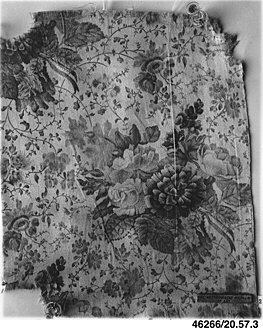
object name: fragment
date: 1801-1900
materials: silk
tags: flowers,leaves